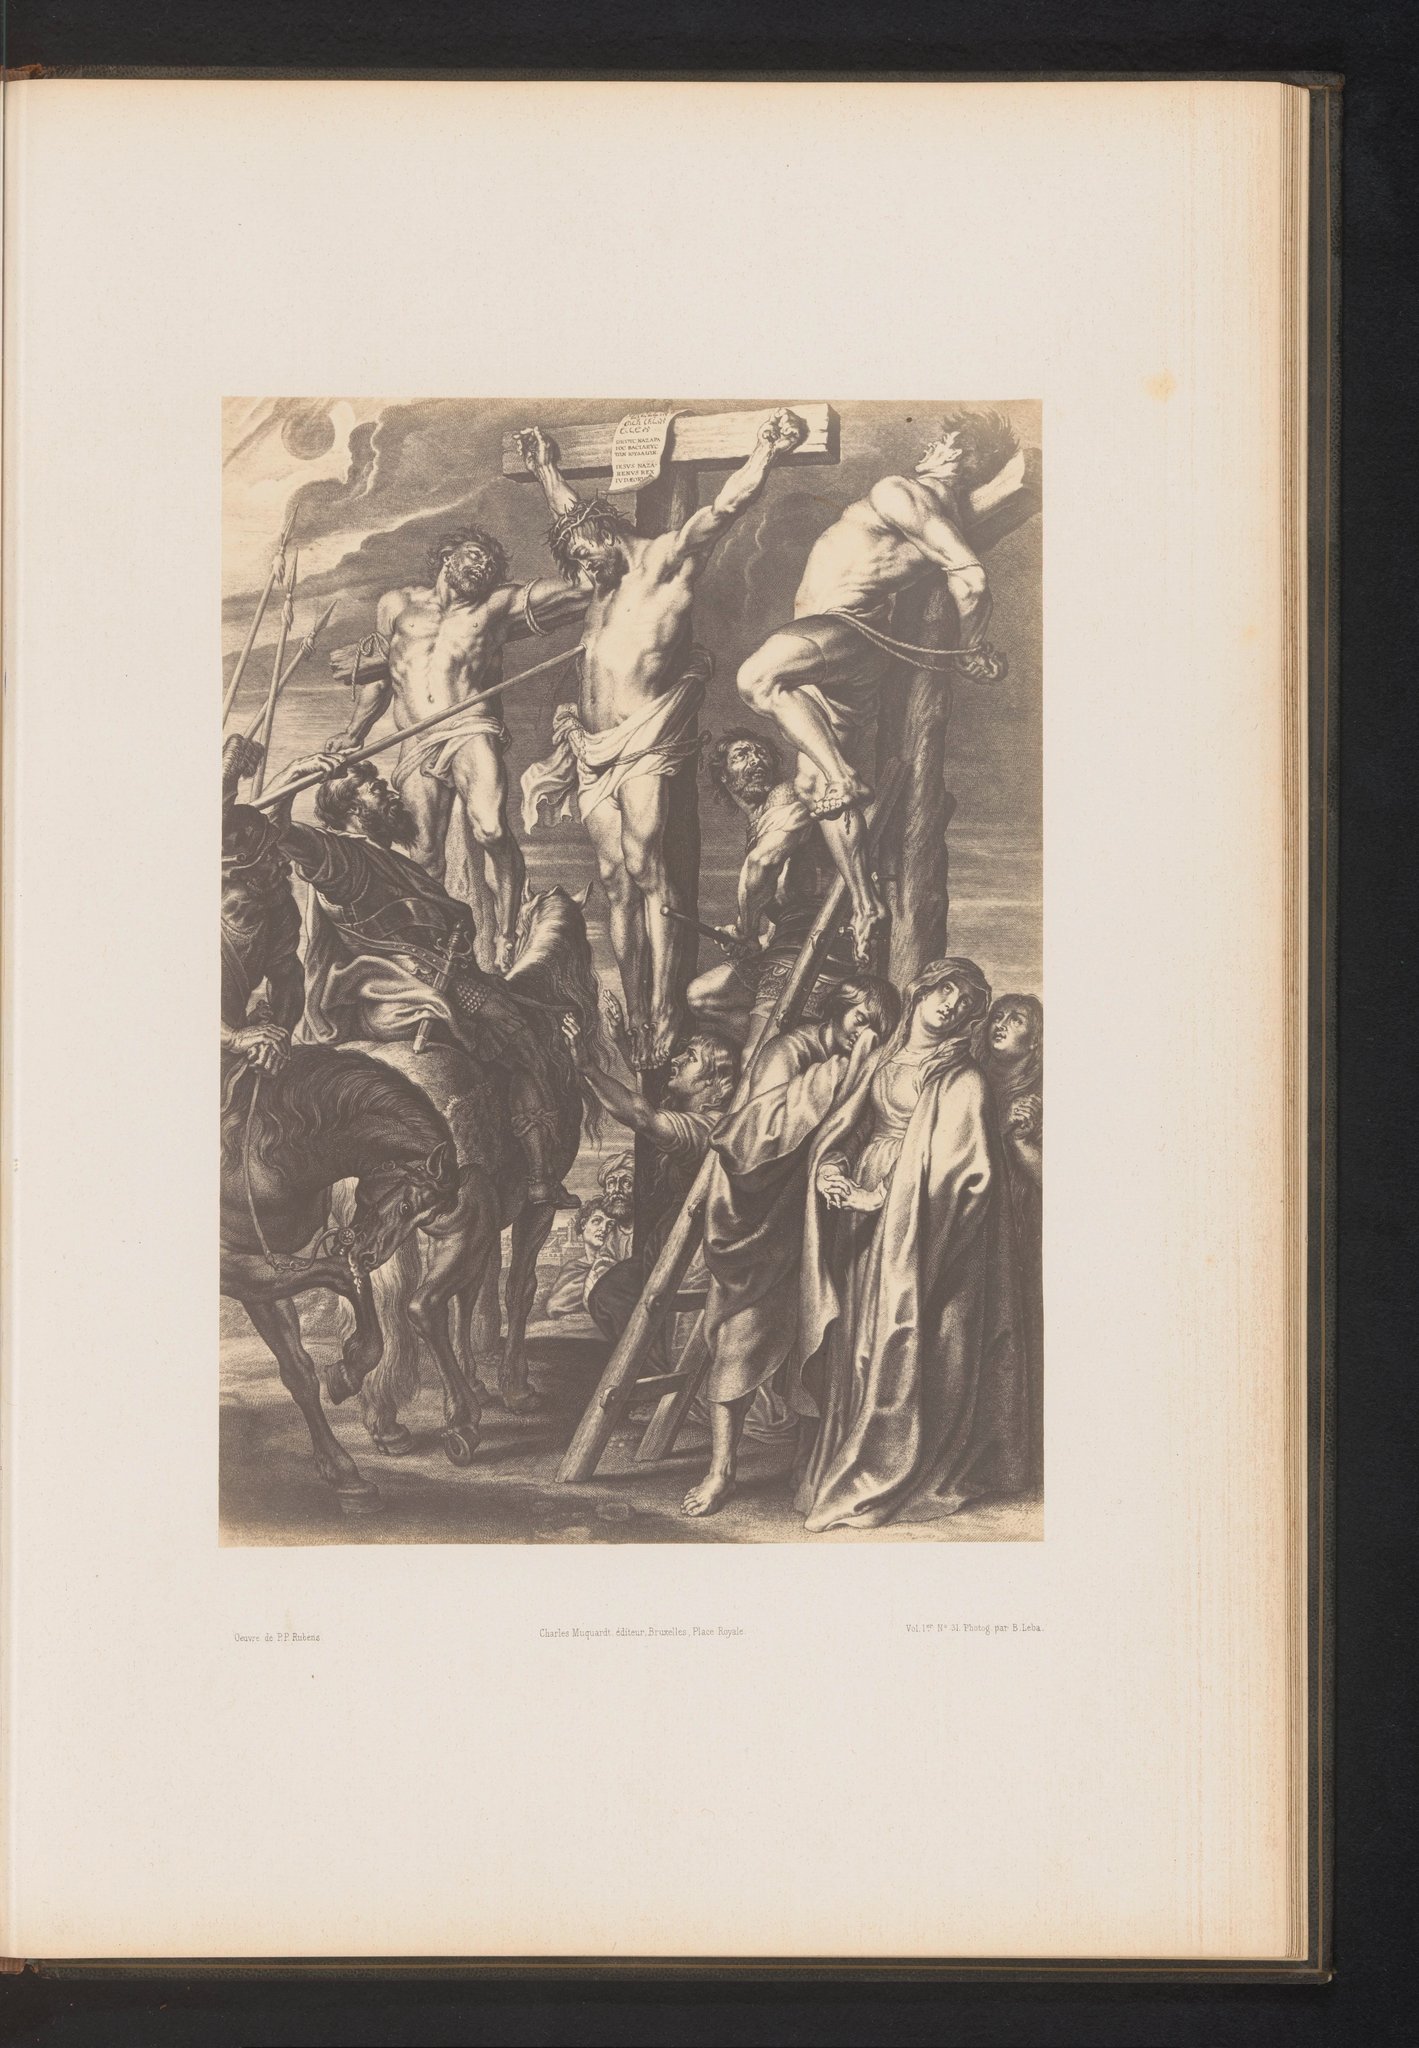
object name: reproduction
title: Fotoreproductie van een gravure van De kruisiging door Schelte Adamsz. Bolswert, naar het schilderij door Peter Paul Rubens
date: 1853-1858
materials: photographic support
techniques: albumen print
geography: brussels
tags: crucified christ with mary, john, and mary magdalene - dd - the three crosses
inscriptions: number: ‘Vol. 1er. No 31.’